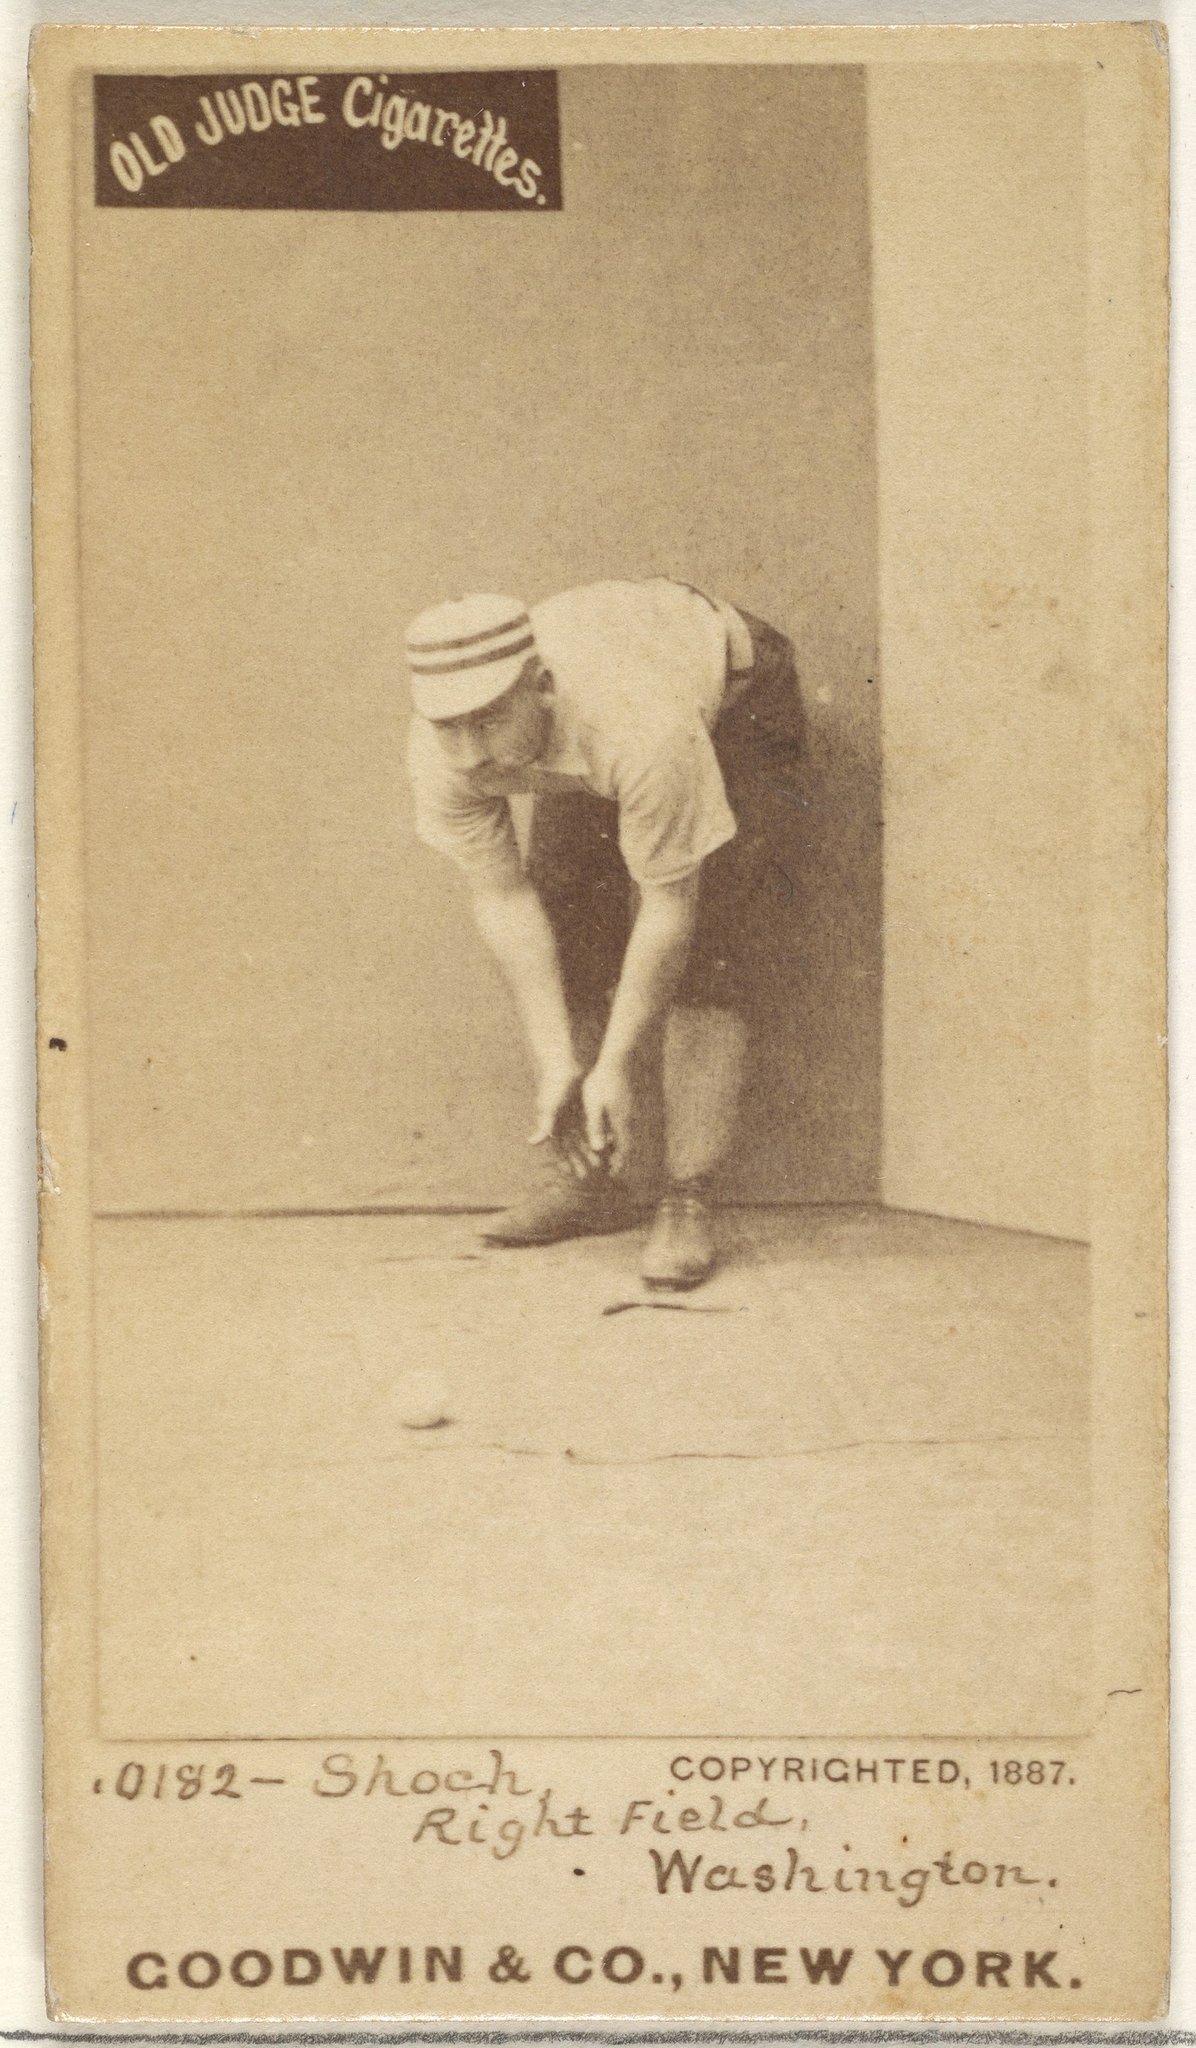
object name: baseball card, photograph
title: George Quintus Shoch, Right Field, Washington Nationals, from the Old Judge series (N172) for Old Judge Cigarettes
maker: goodwin & company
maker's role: publisher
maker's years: 1850-1950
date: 1887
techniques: albumen silver print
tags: men,portraits,baseball,athletes